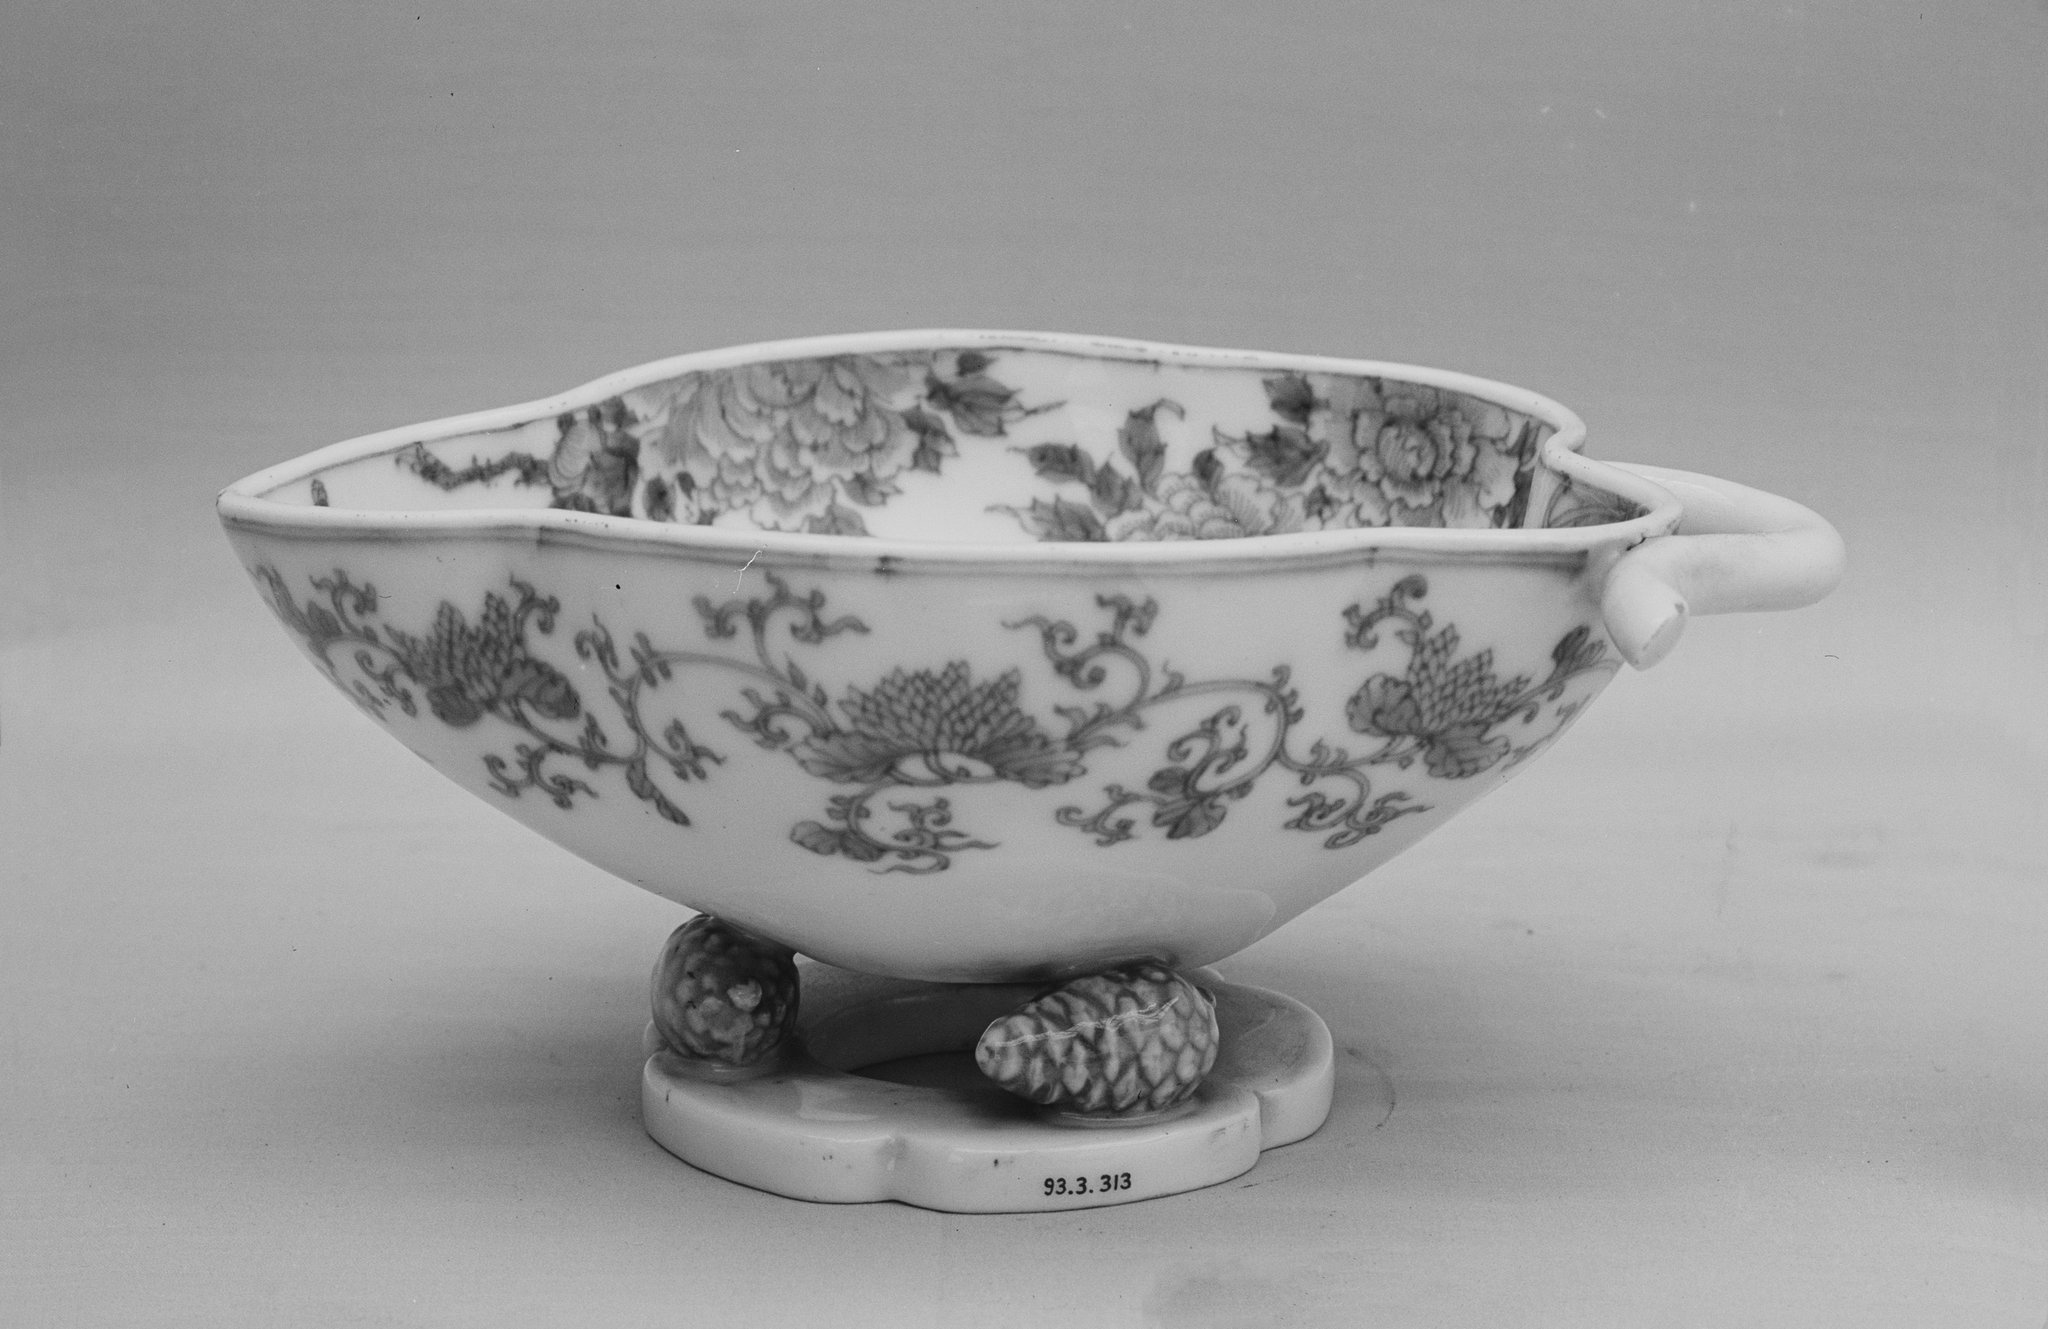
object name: saucer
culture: japanese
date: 1840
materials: glaze, porcelain